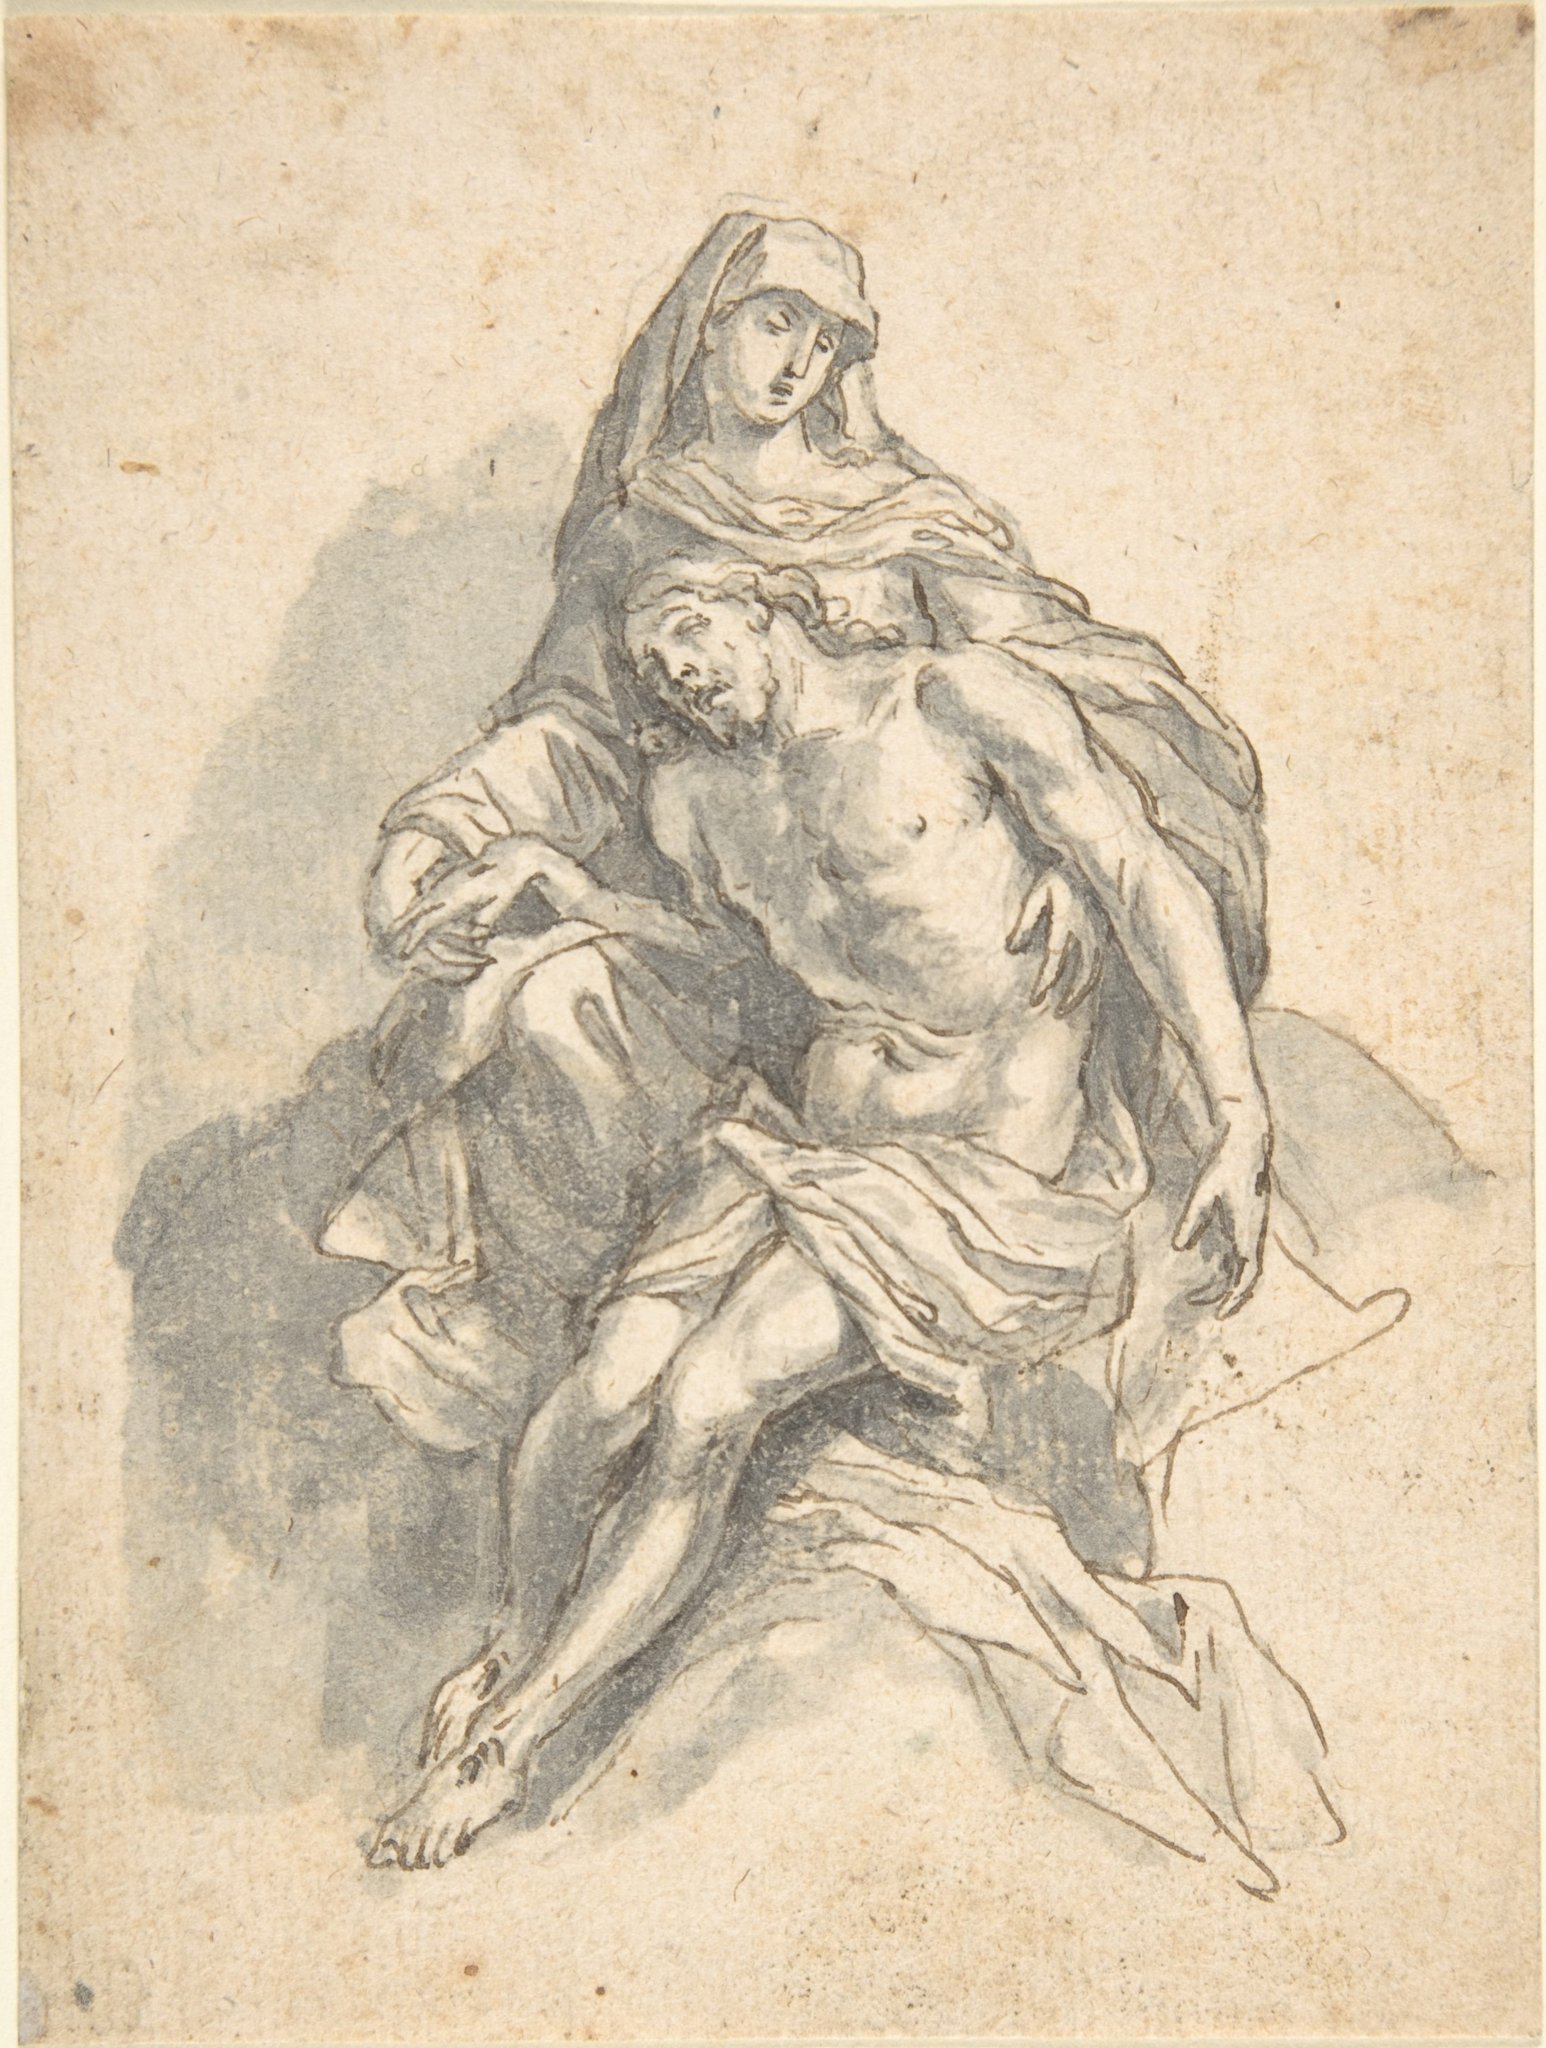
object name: drawing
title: Pietà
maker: anonymous, german, 17th century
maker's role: artist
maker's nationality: german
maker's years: 1600-1700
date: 1601-1800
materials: chalk, ink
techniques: brush, pen, wash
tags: christ,virgin mary